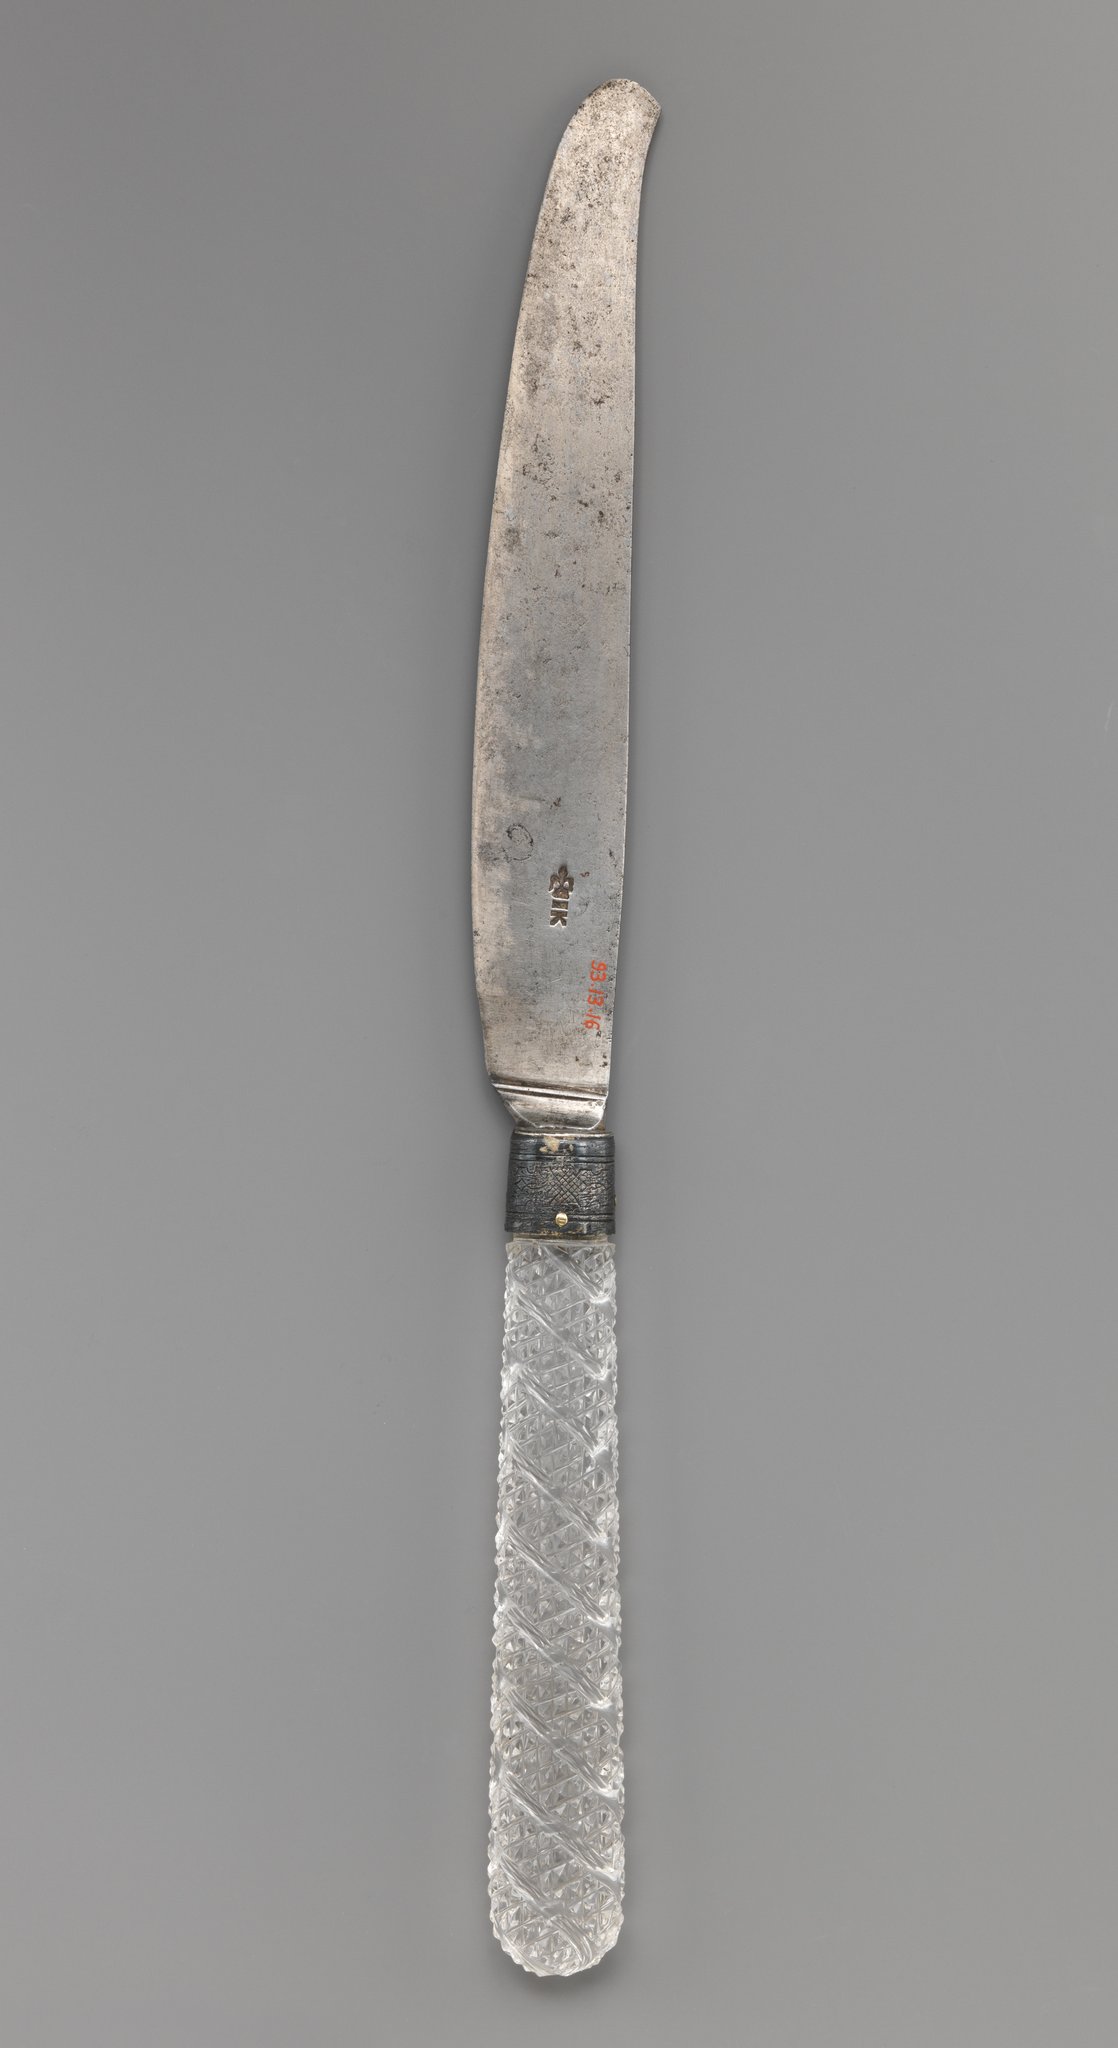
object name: knife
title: Table (carving?) knife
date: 1767-1800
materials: glass, steel